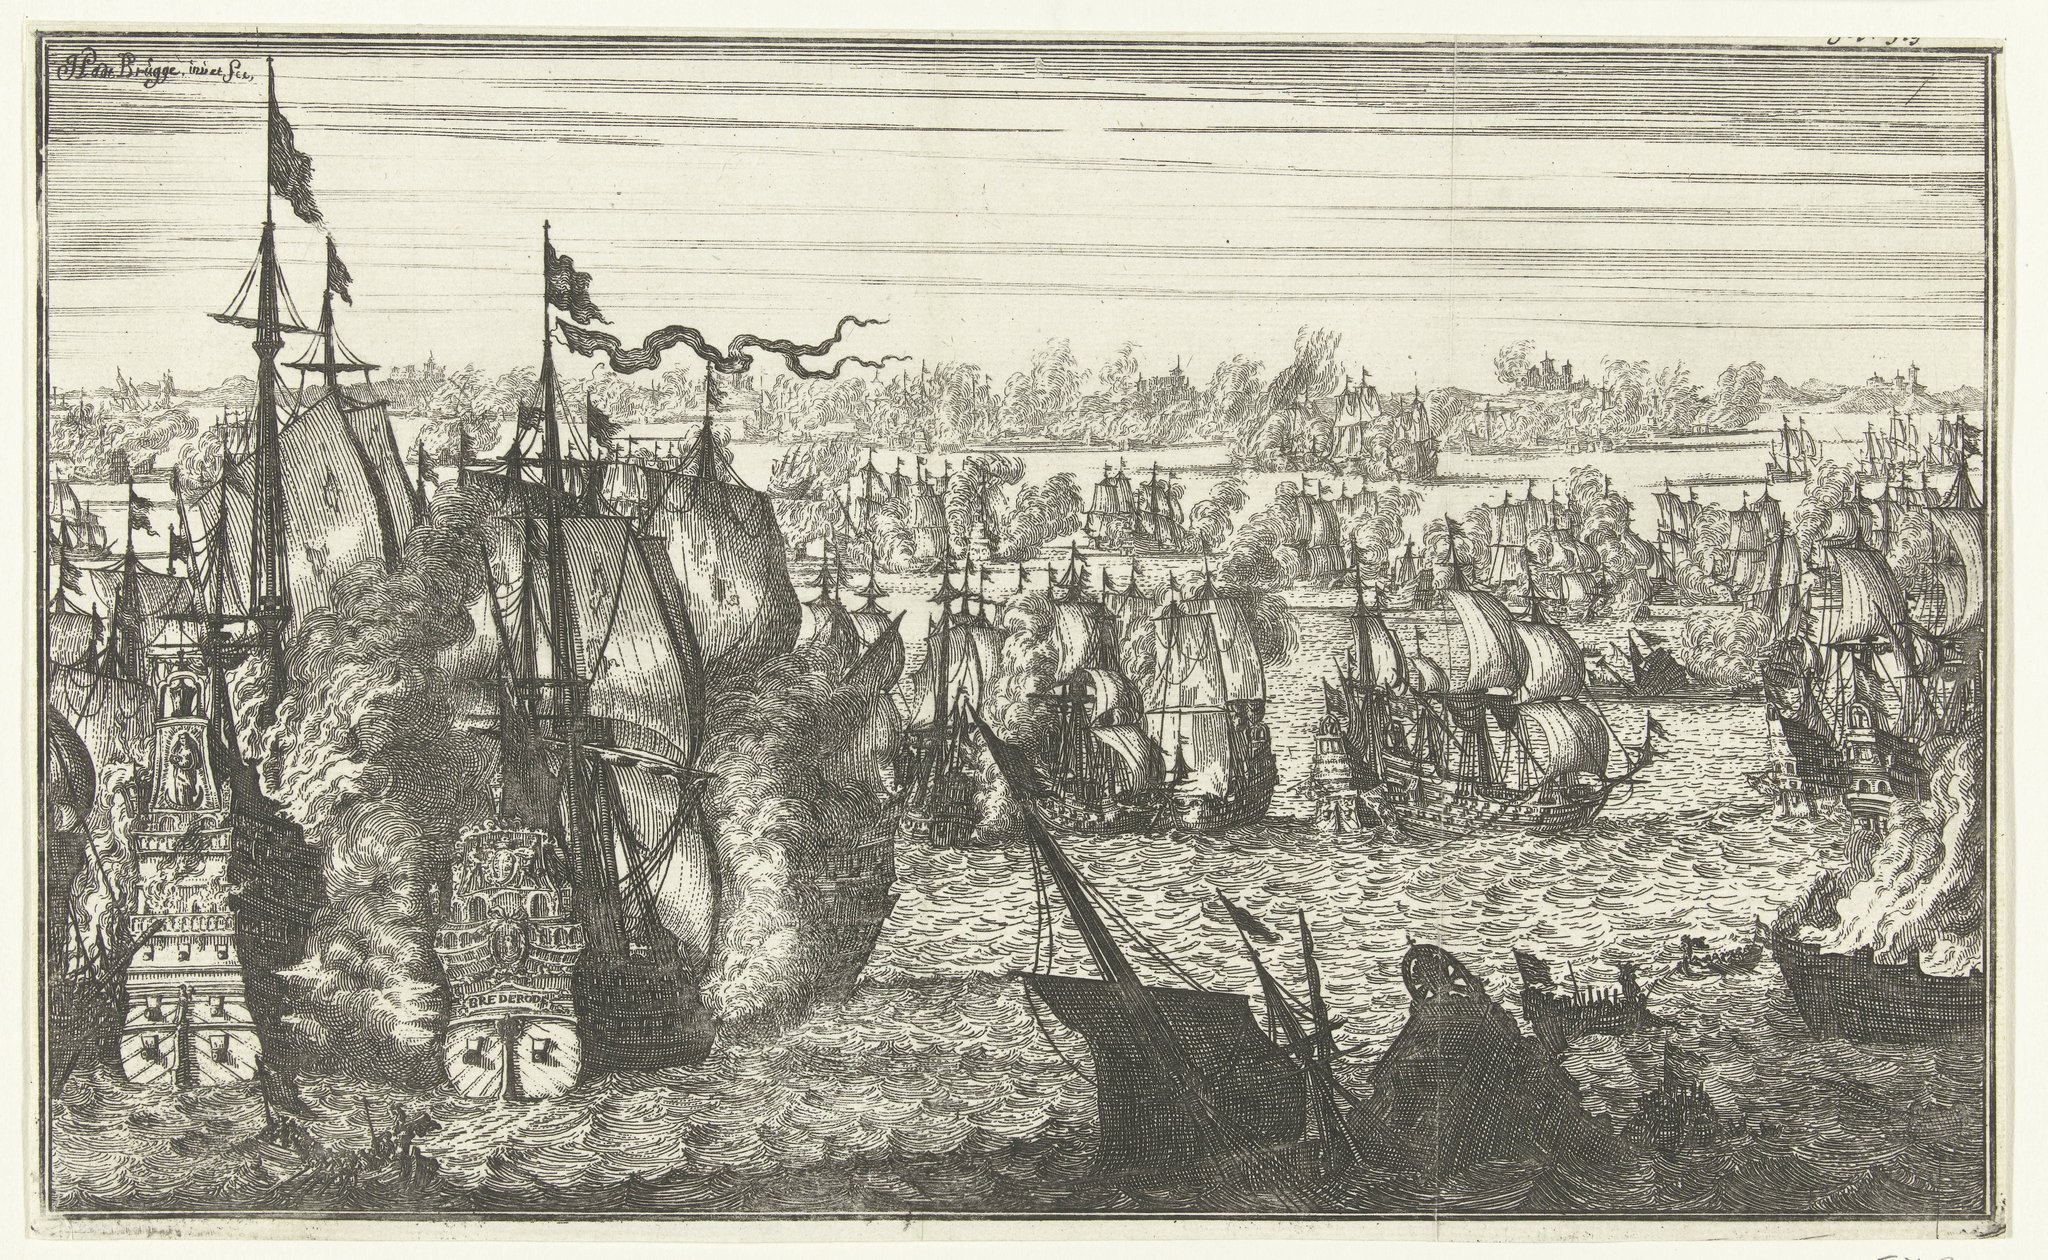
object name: print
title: Zeeslag bij Duins, 1639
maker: herman padtbrugge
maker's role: print maker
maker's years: 1656-1687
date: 1674-1676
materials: paper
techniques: etching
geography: northern netherlands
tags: brielle, maarten harpertszoon tromp, battle (+ naval force), battle of the downs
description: Eerste staat met afbeelding van Maria op de spiegel van het Spaanse schip en de naam Brederode op de spiegel van het Hollandse schip. Gebruikt als illustratie in: Lambertus van den Bosch, Leeven en daden der doorluchtighste zeehelden, Jan Claesz ten Hoorn & Jan Bouman, Amsterdam 1676, dl. 2, p. 92/93 bij de beschrijving van de slag bij Duins in 1639. In deze staat (met andere deel en paginanummer rechtsboven) niet uit de editie van van 1676, maar wellicht uit de editie van 1683. Volgens Muller in het Supplement illustreert deze prent niet de zeeslag bij Duins maar de zeeslag bij Katwijk (Ter Heide) in 1653.